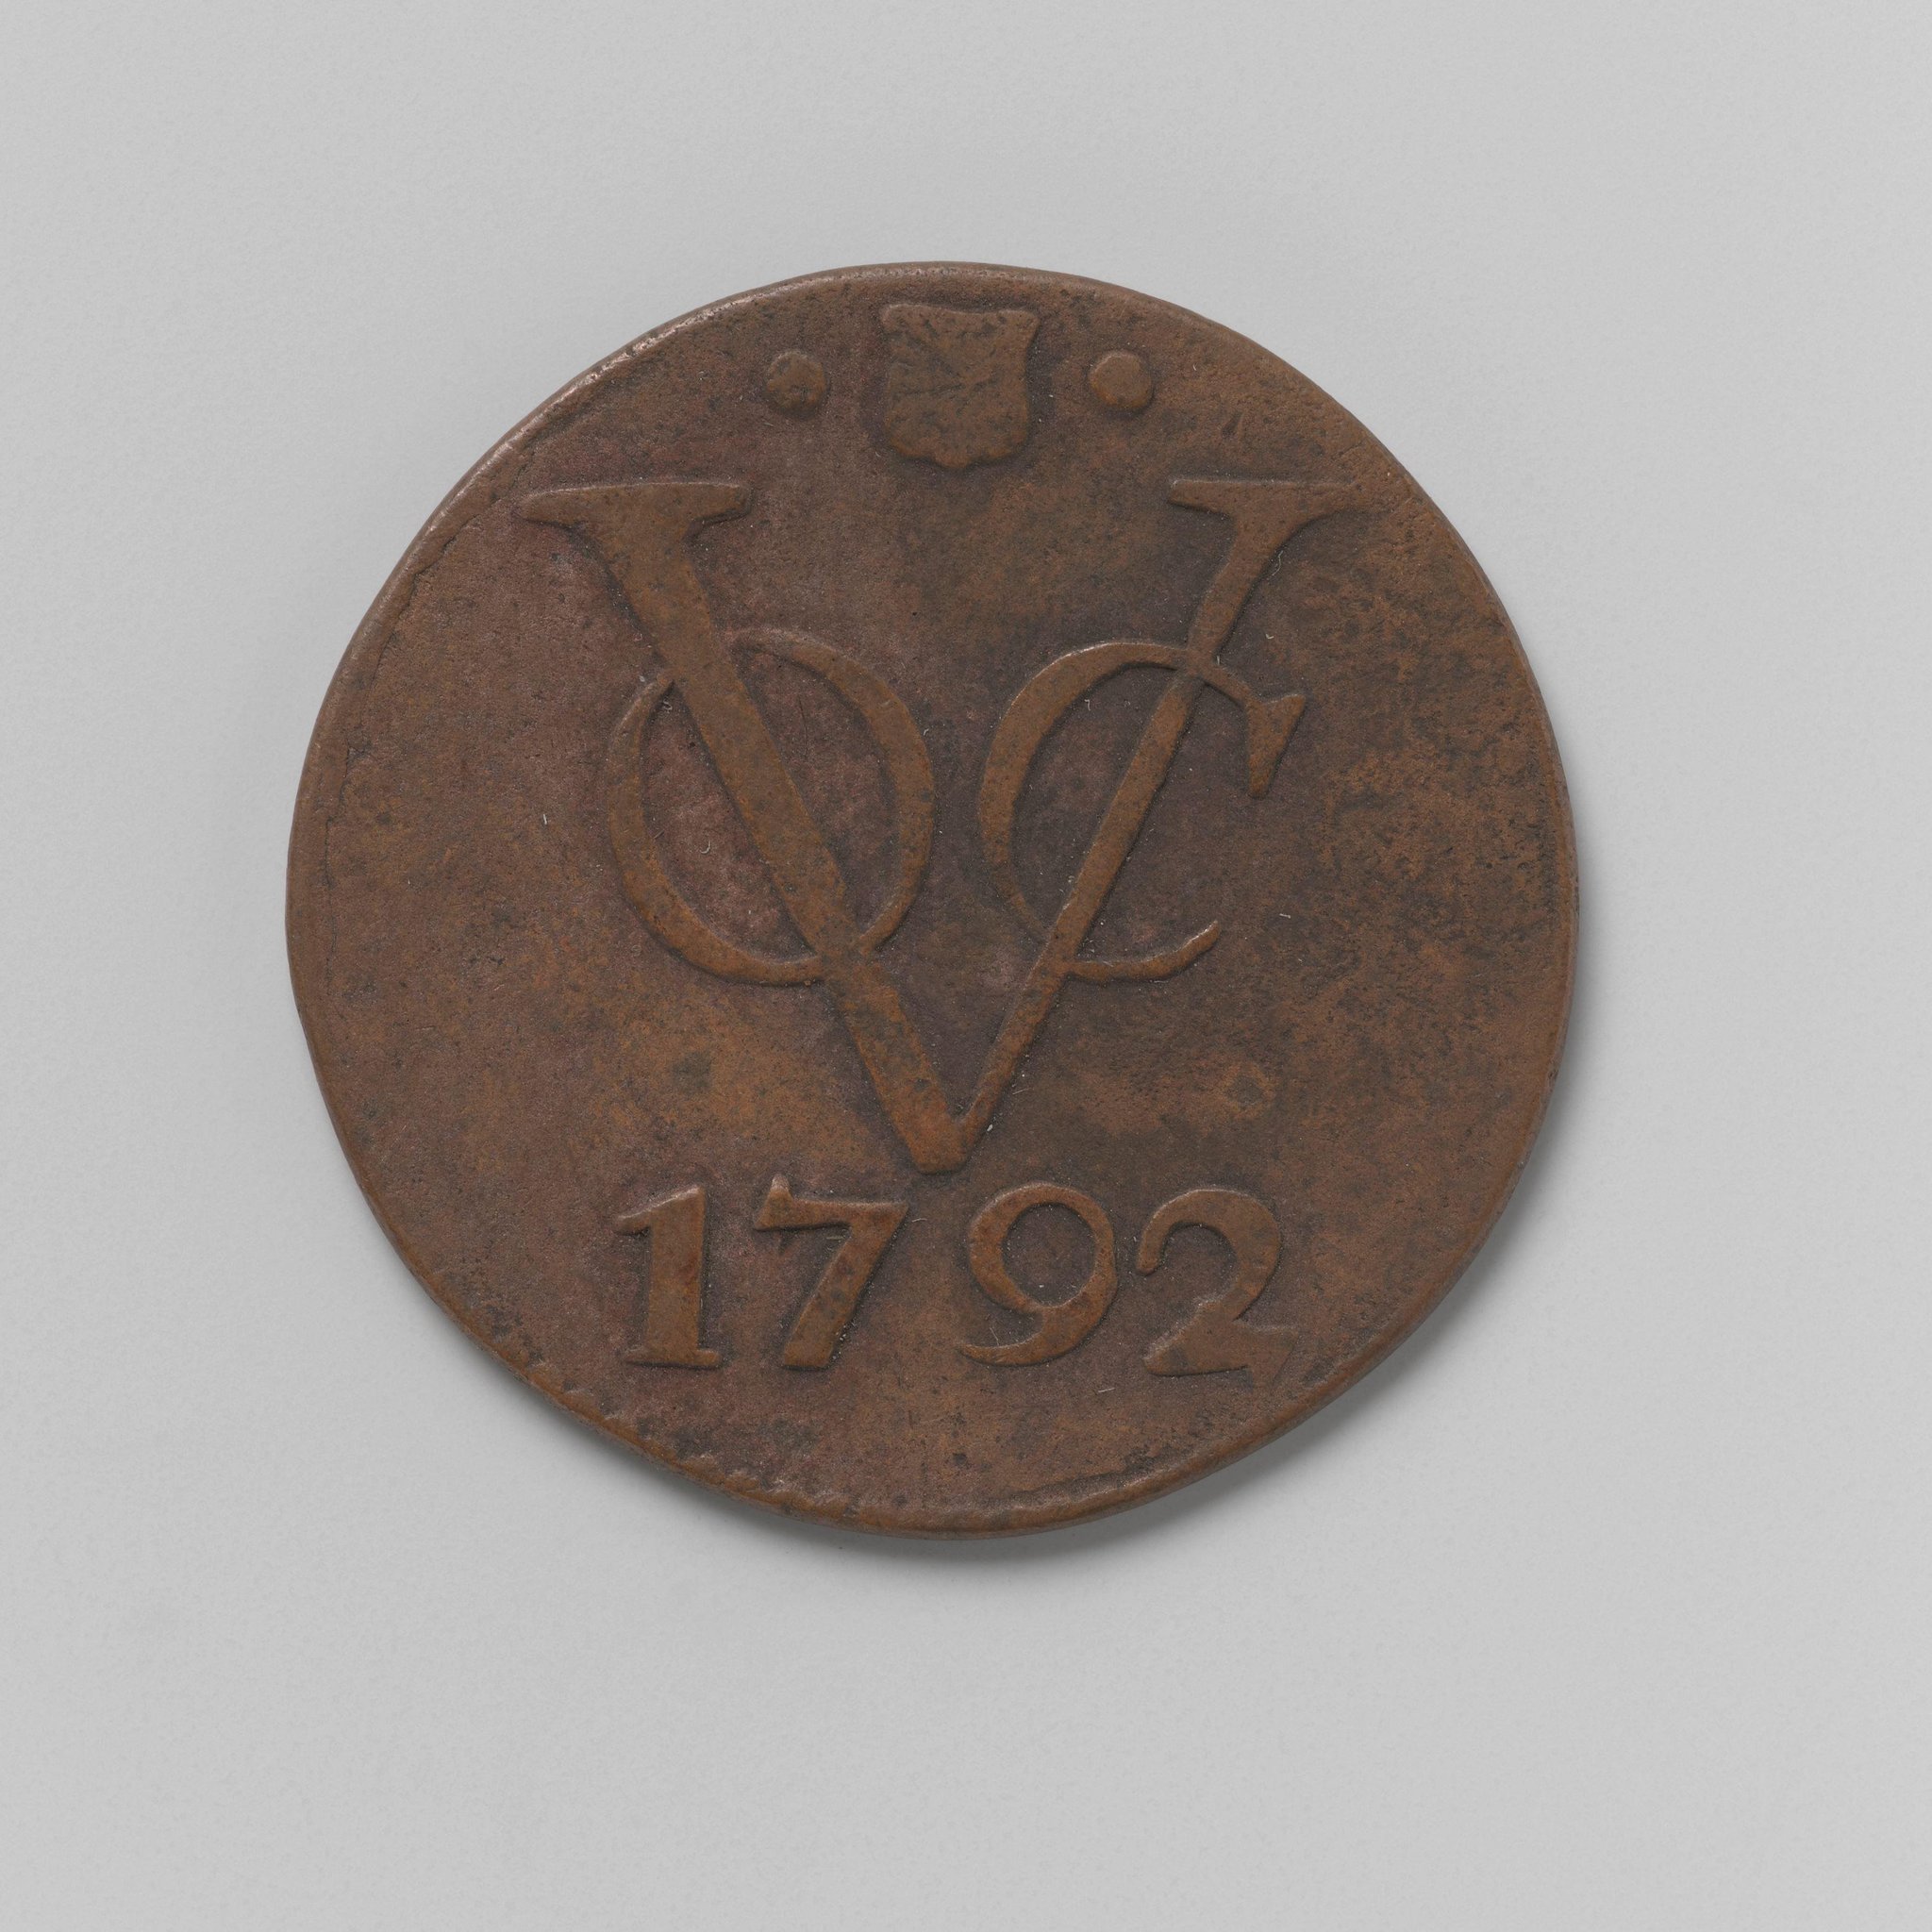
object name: coin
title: VOC, duit, stad Utrecht,1792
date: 1792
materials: copper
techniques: striking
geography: utrecht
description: Koperen munt. Voorzijde: op balk, waaronder guirlande, staand, door twee leeuwen gehouden gekroond wapenschild van de stad Utrecht. Keerzijde: monogram van de VOC, waarboven muntteken en waaronder jaartal. Gladde rand.